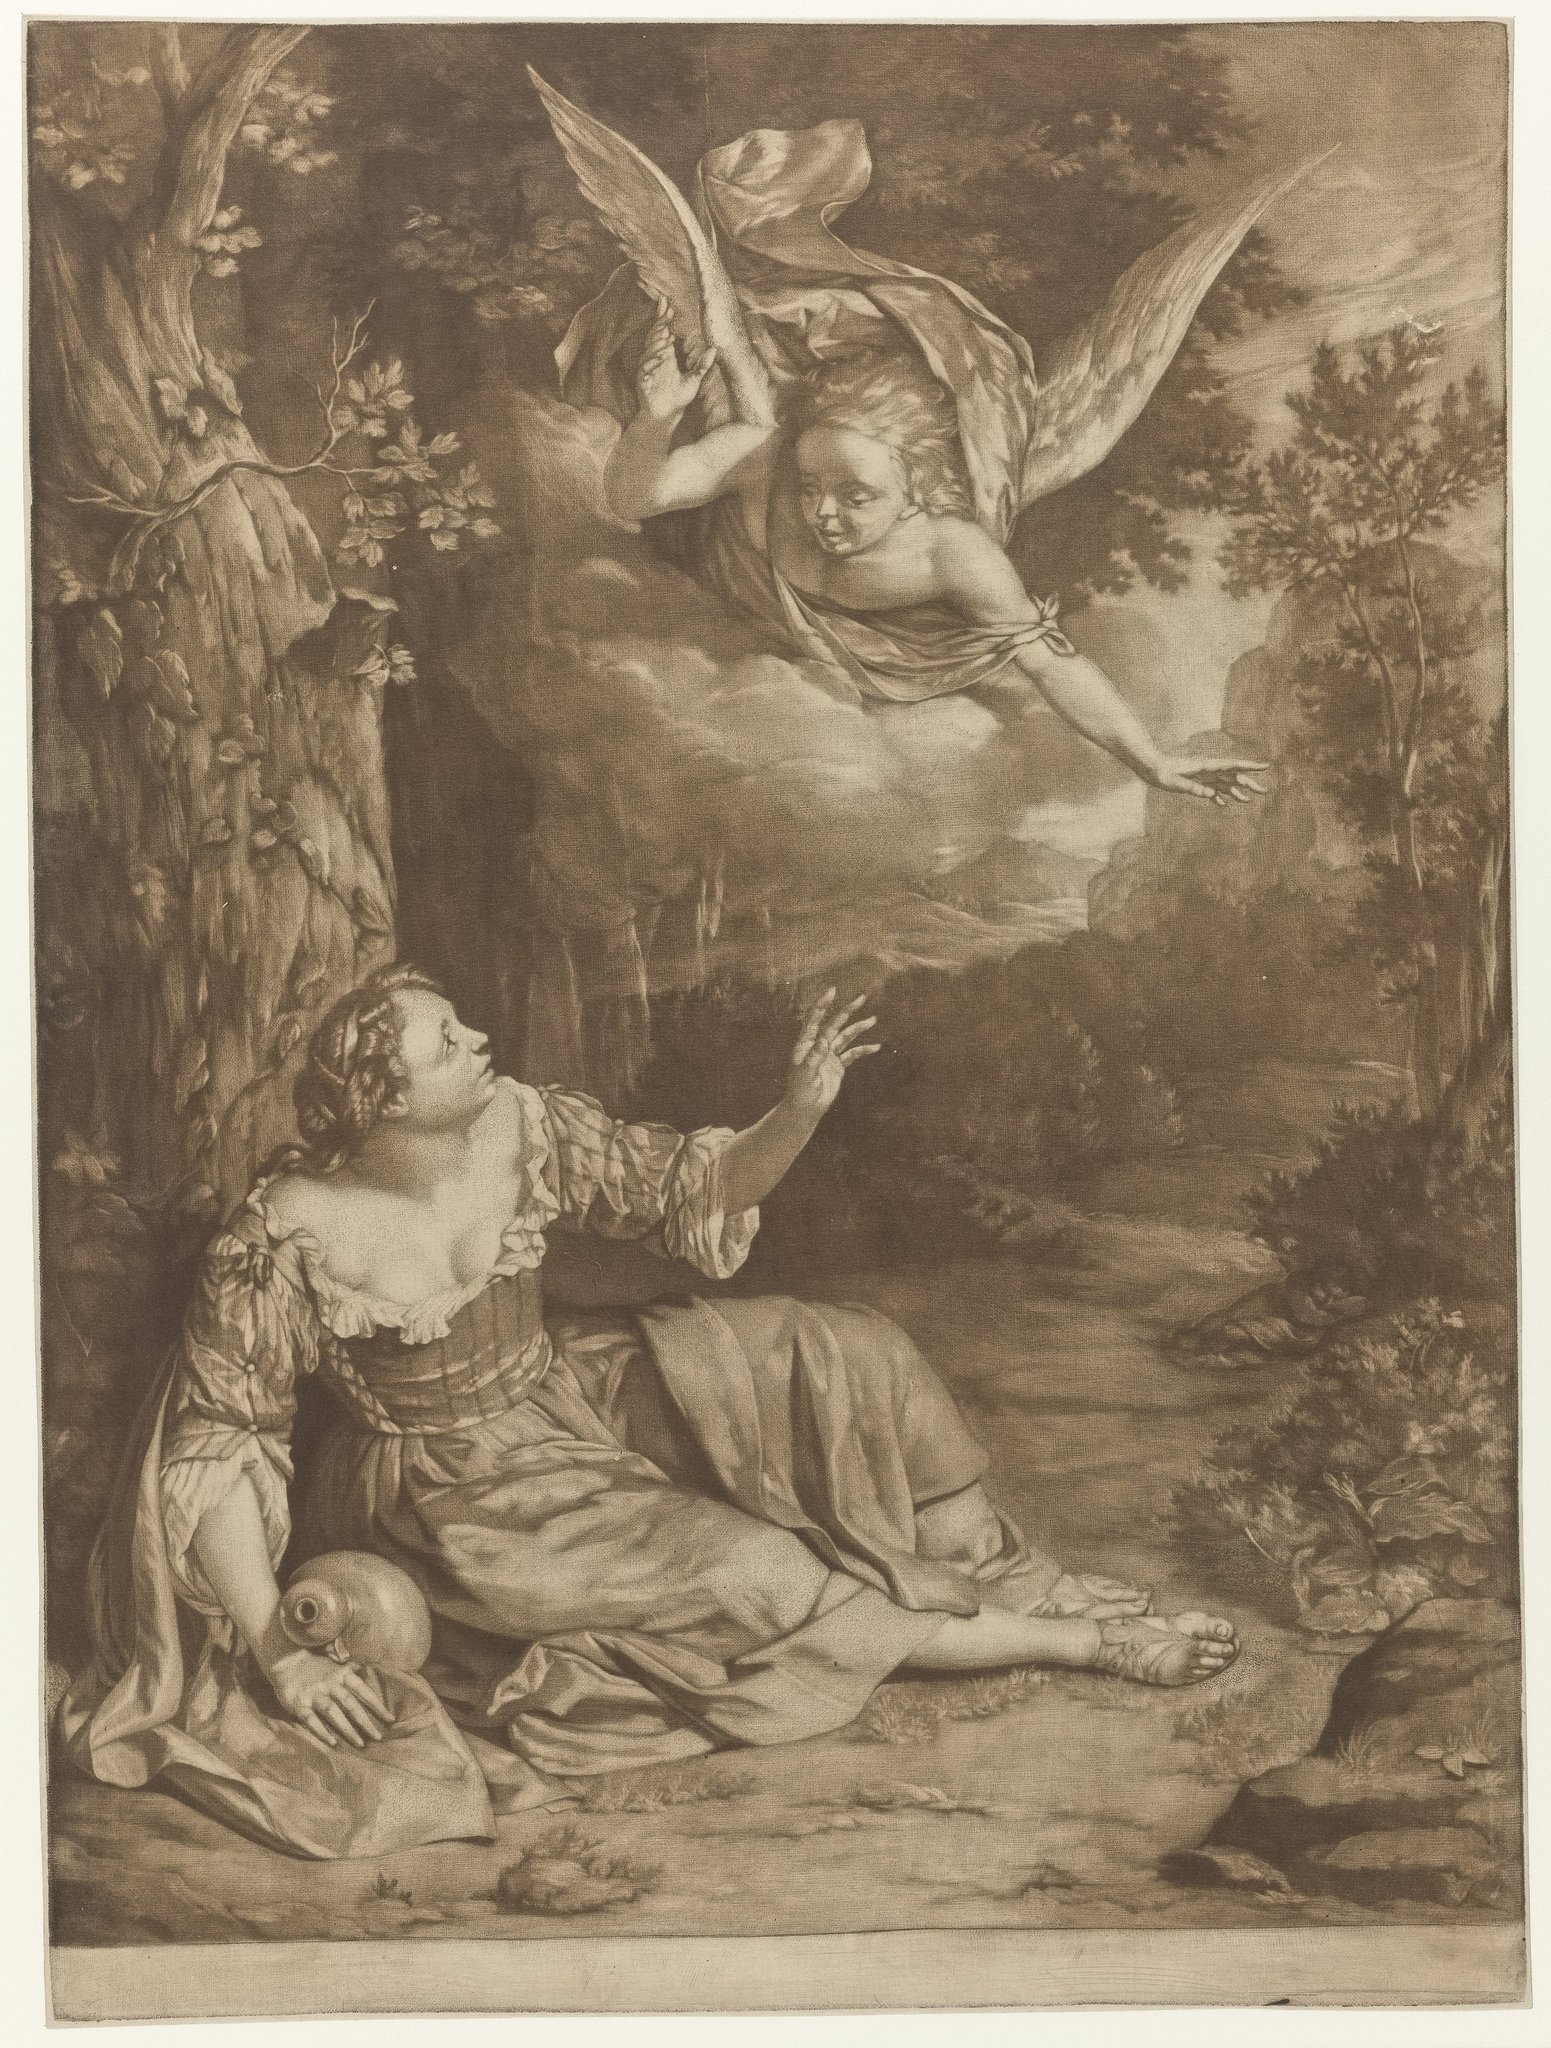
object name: print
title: Hagar en Ismaël in de wildernis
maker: nicolaas verkolje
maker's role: draughtsman, painter, print maker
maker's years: 1673-1746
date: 1695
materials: paper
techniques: mezzotint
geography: amsterdam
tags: an angel appears and reveals a well of water to hagar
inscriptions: collector's mark: Lugt 240, signature and date: ‘Nicolas Verkolje inv: et fecit 1694’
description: Een engel wijst Hagar de weg naar een bron. Op de achtergrond ligt haar zoon Ismaël op de grond te slapen.